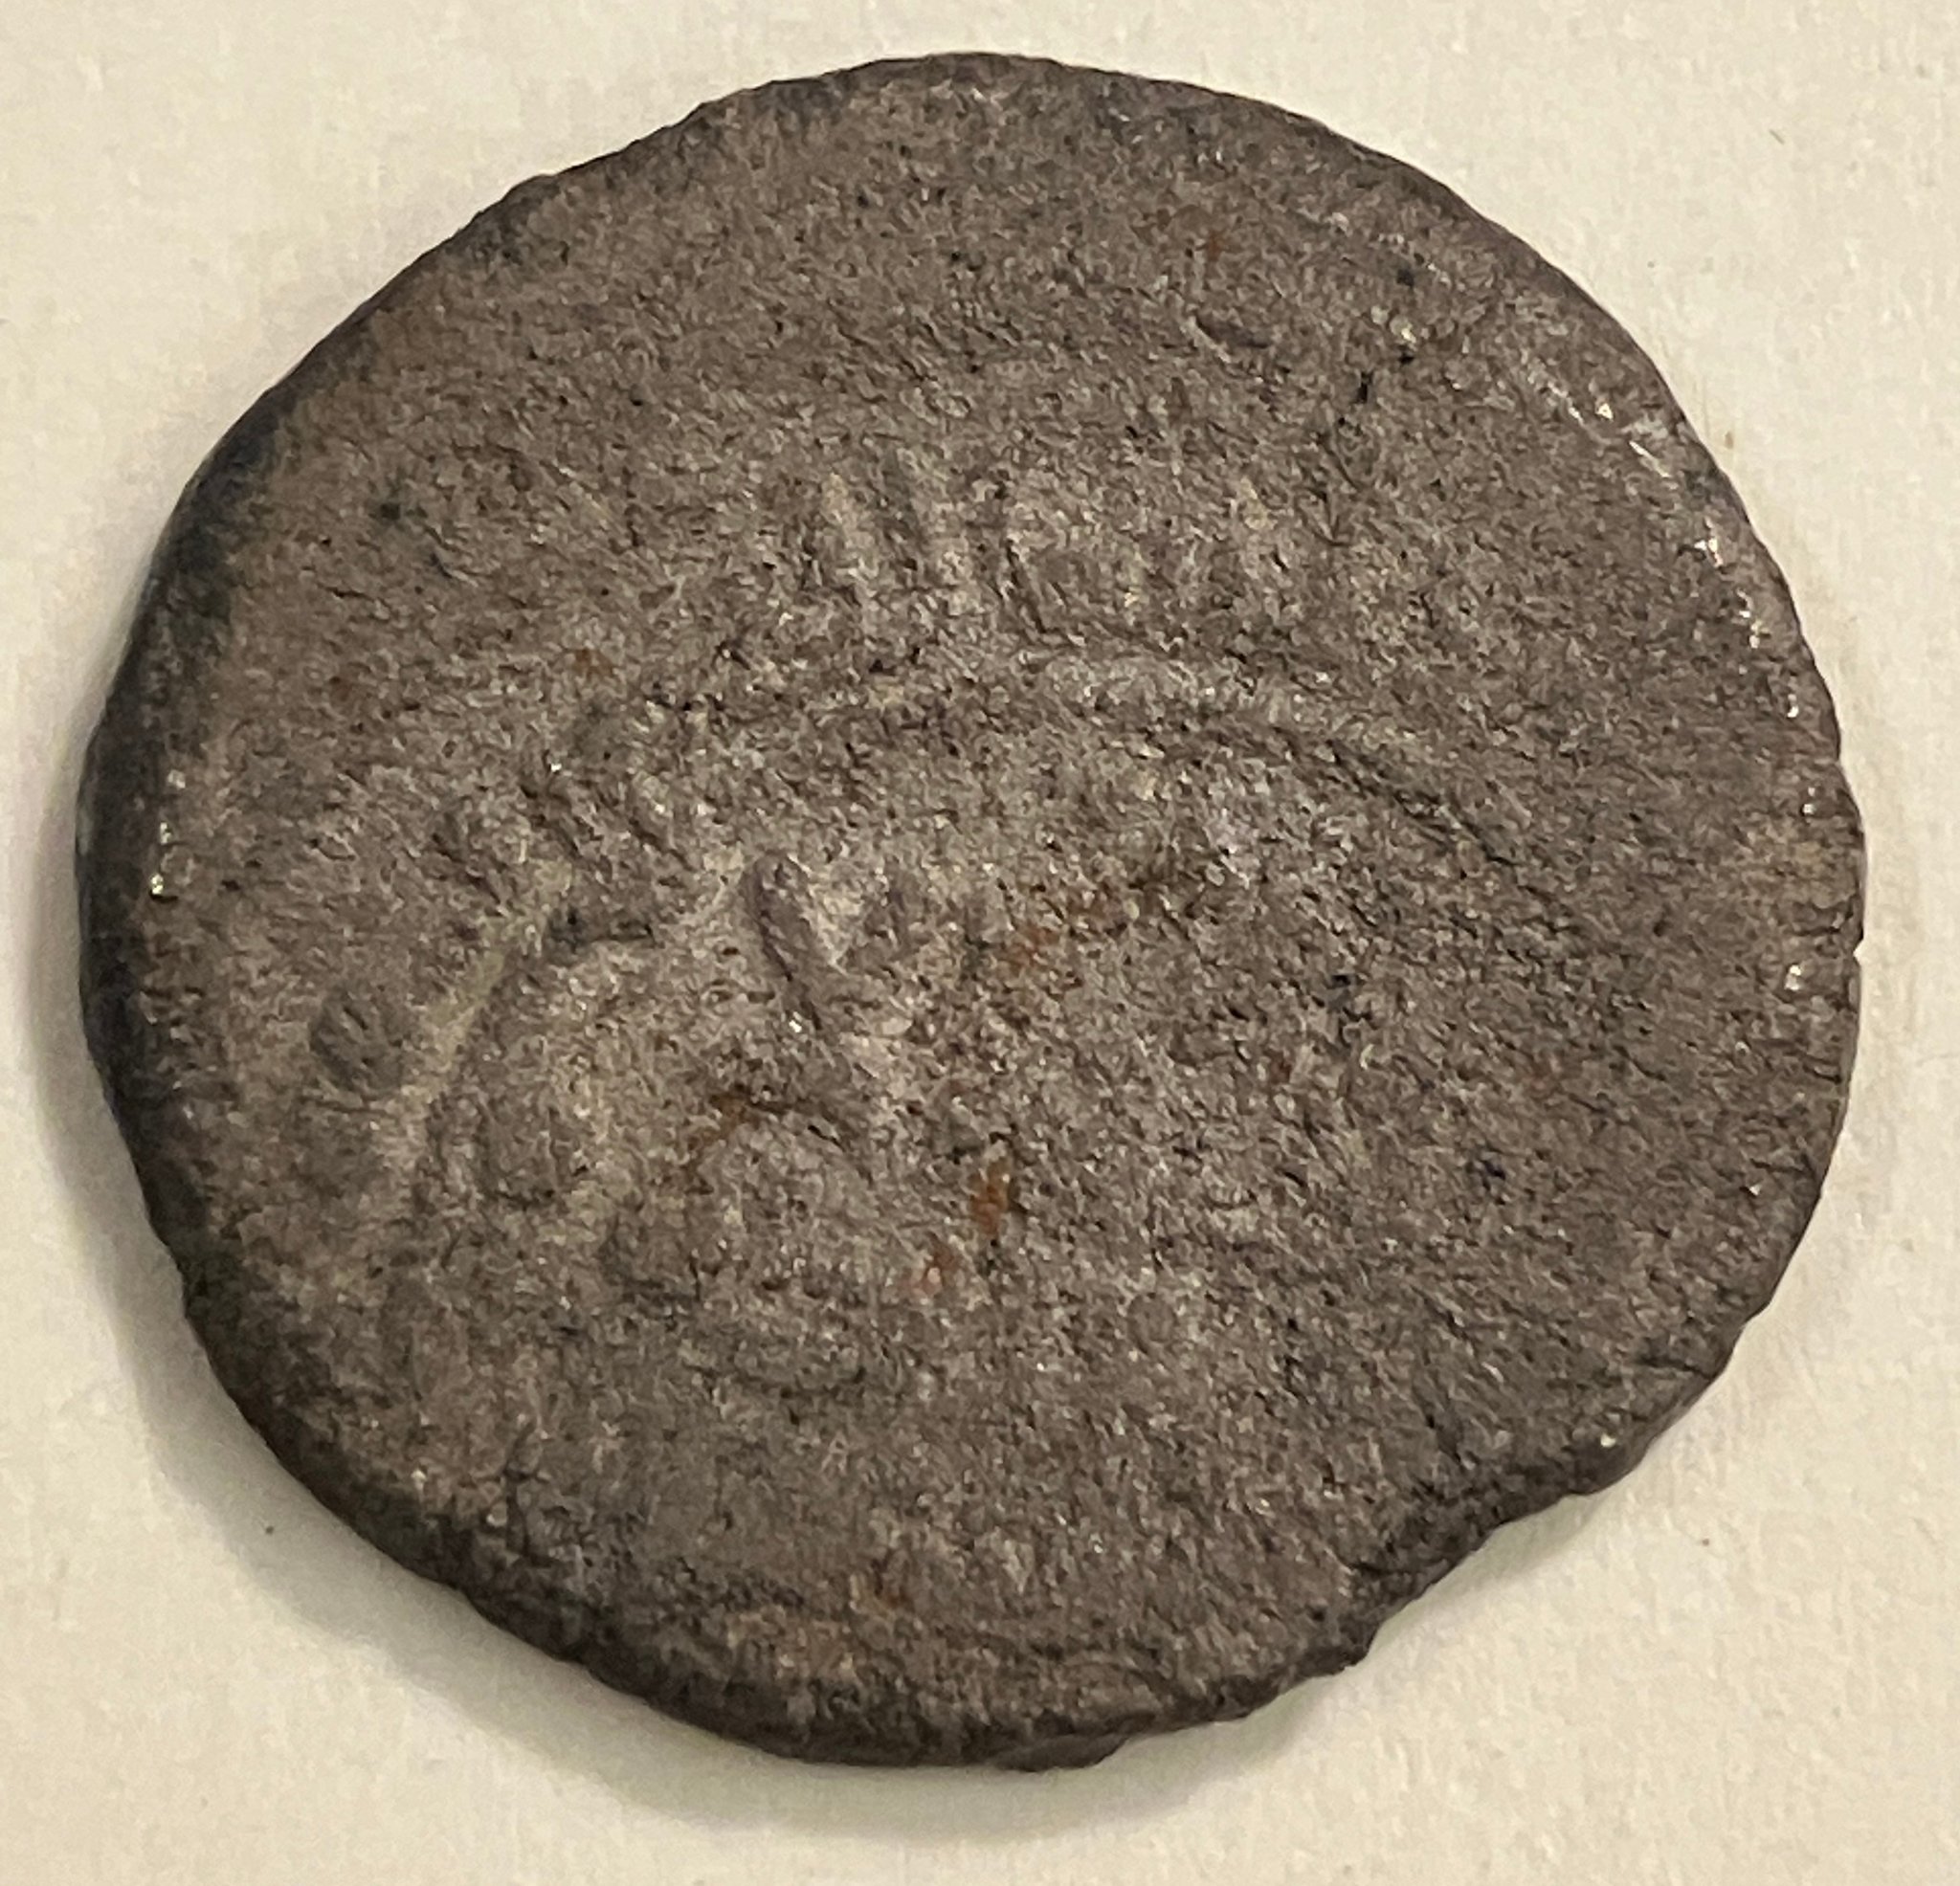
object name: coin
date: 401-1400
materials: copper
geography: iran